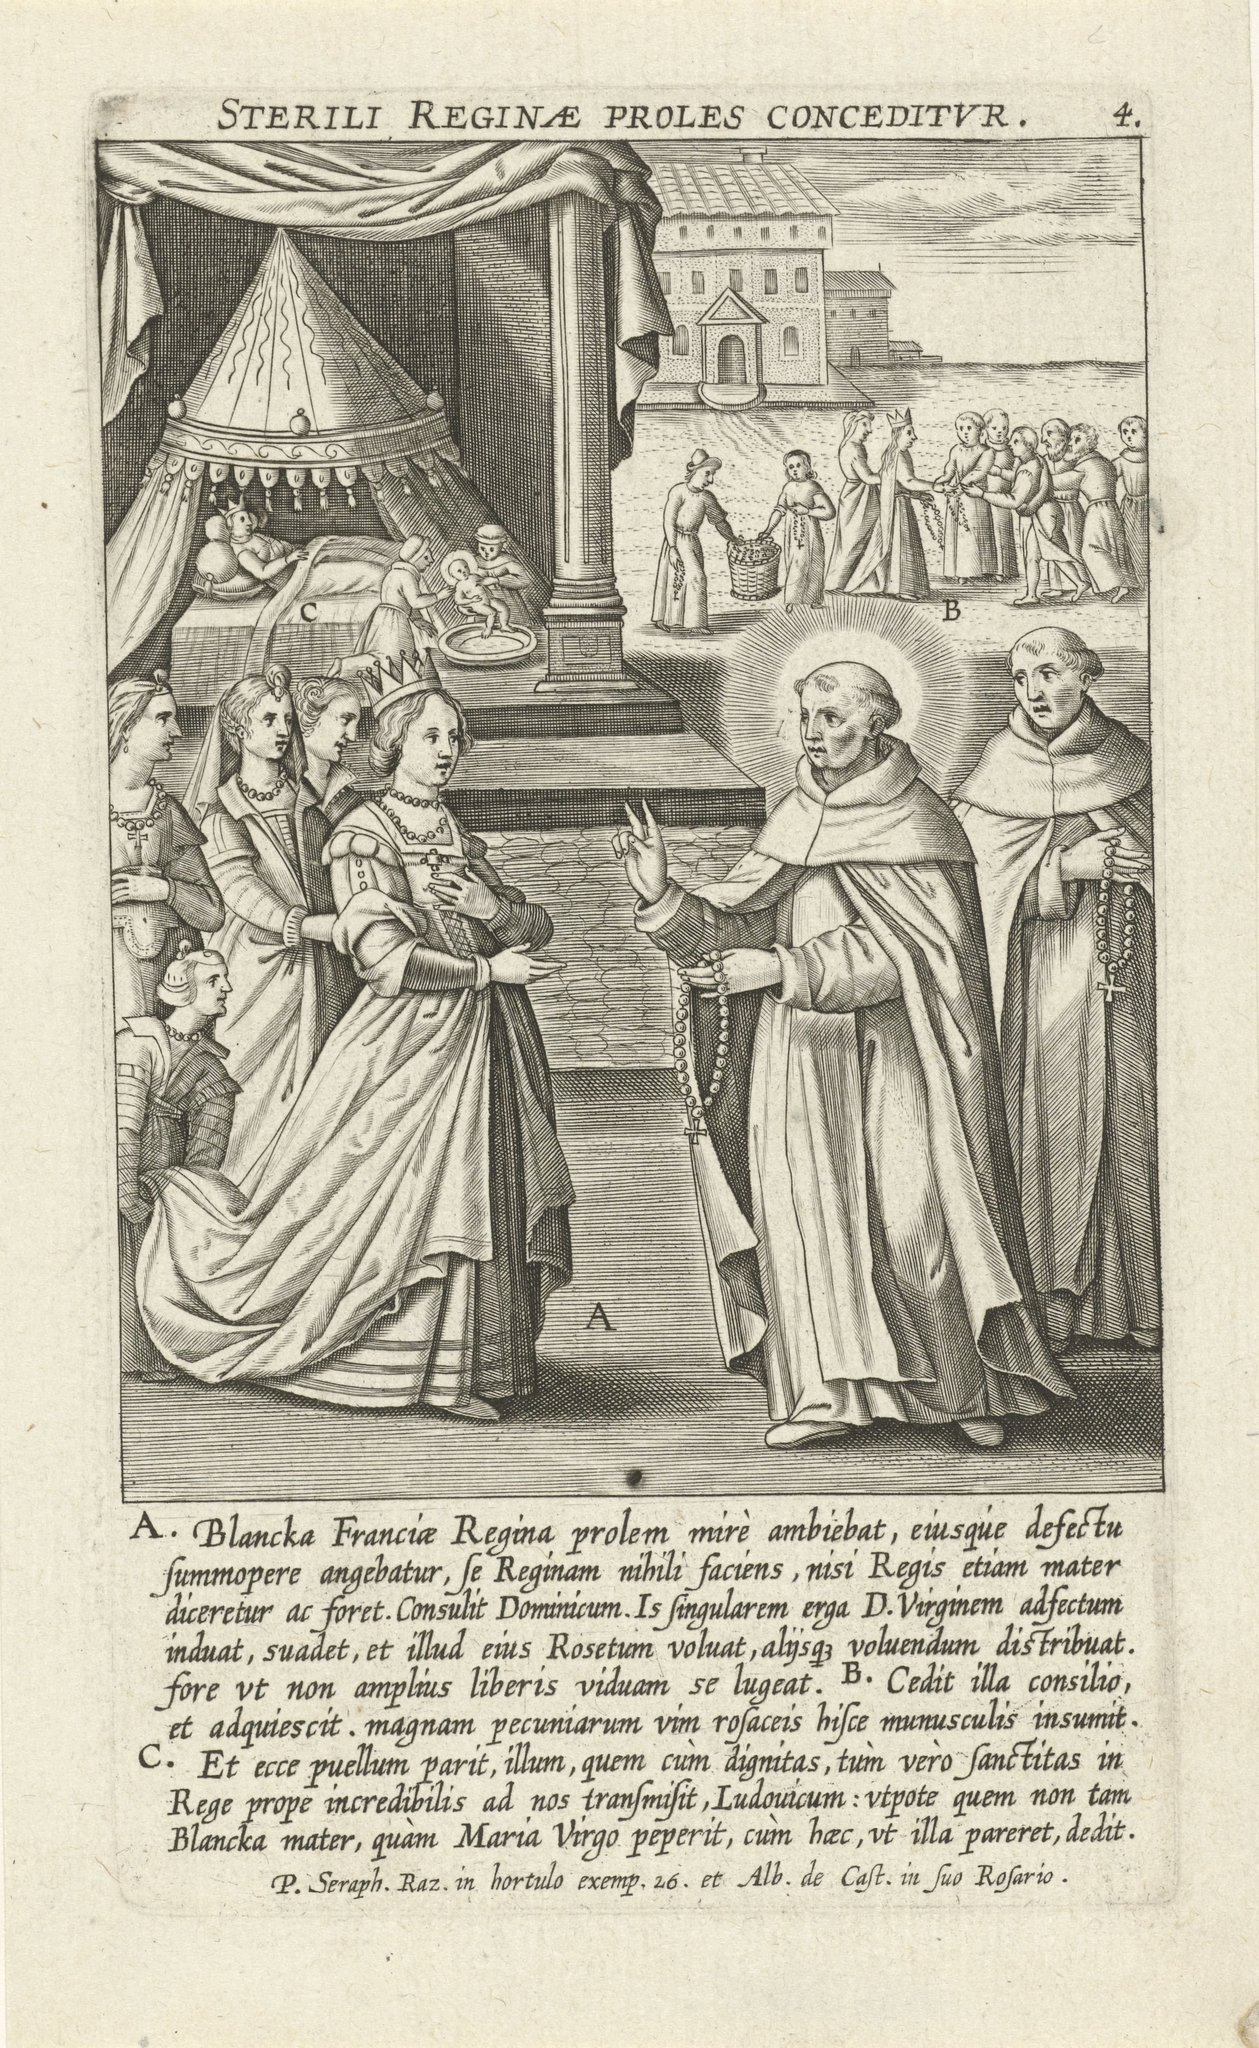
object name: print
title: Sterili reginea proles conceditvr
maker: theodoor galle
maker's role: print maker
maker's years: 1571-1633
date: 1610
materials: paper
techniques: engraving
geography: antwerp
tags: miraculous activities and events ~ st. dominic, aids for prayer, e.g. rosary (+ variant), queen, empress, etc. (wife of a ruler), confinement, birth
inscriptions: collector's mark: Lugt 2228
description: De heilige Dominicus geeft de onvruchtbare koningin Blanca van Castilië een rozenkrans. Hij raadt haar aan te bidden tot Maria voor een kind. Op de achtergrond de geboorte van Blanca's eerste kind. De prent heeft een Latijns onderschrift met legende en maakt deel uit van een vijftiendelige serie over de mirakels van de rozenkrans.